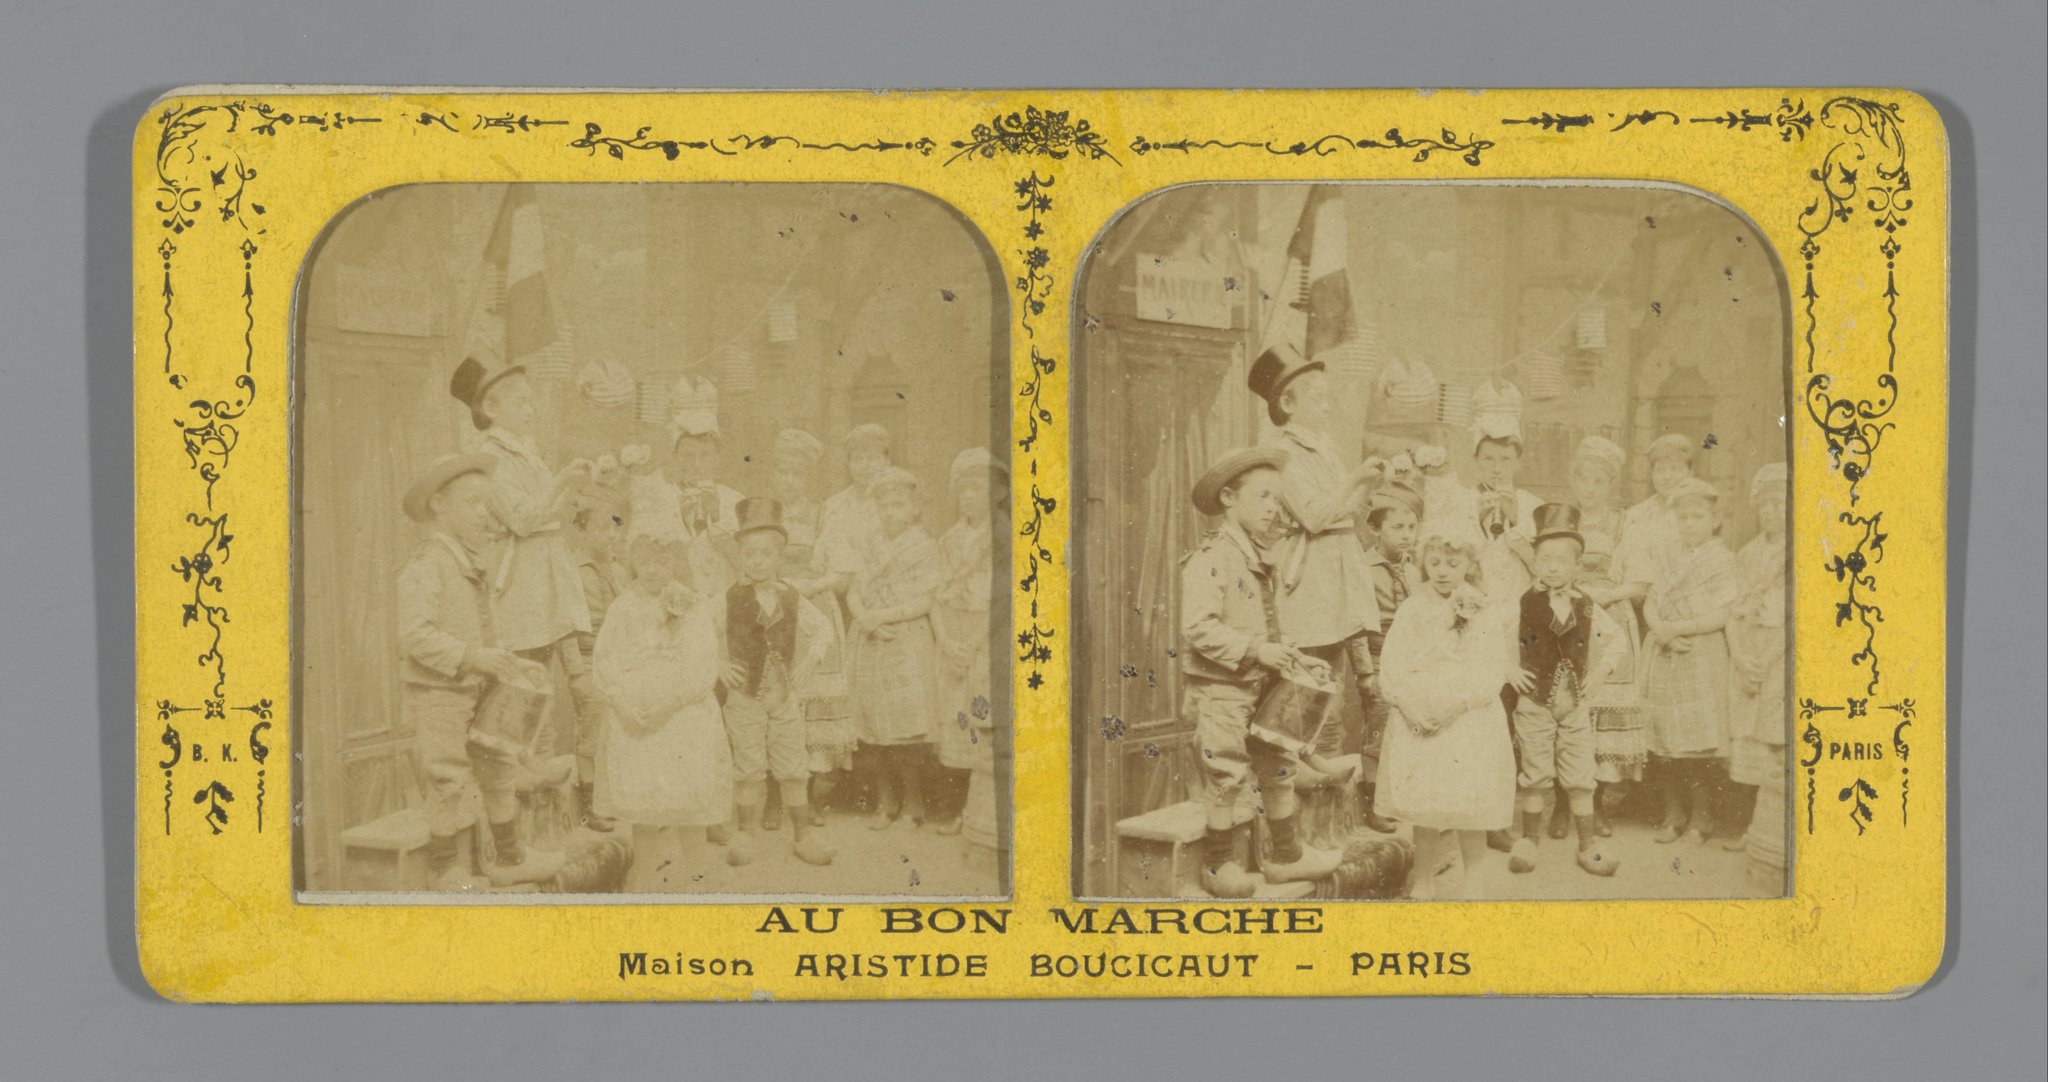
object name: tissue stereograph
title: Kinderfeestje in Frankrijk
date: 1863-1875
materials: cardboard, paper, photographic support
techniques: albumen print, hand coloring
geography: paris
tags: festivities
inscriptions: retailer's mark: ‘AU BON MARCHE/ Maison ARTISTIDE BOUCICAUT - PARIS’